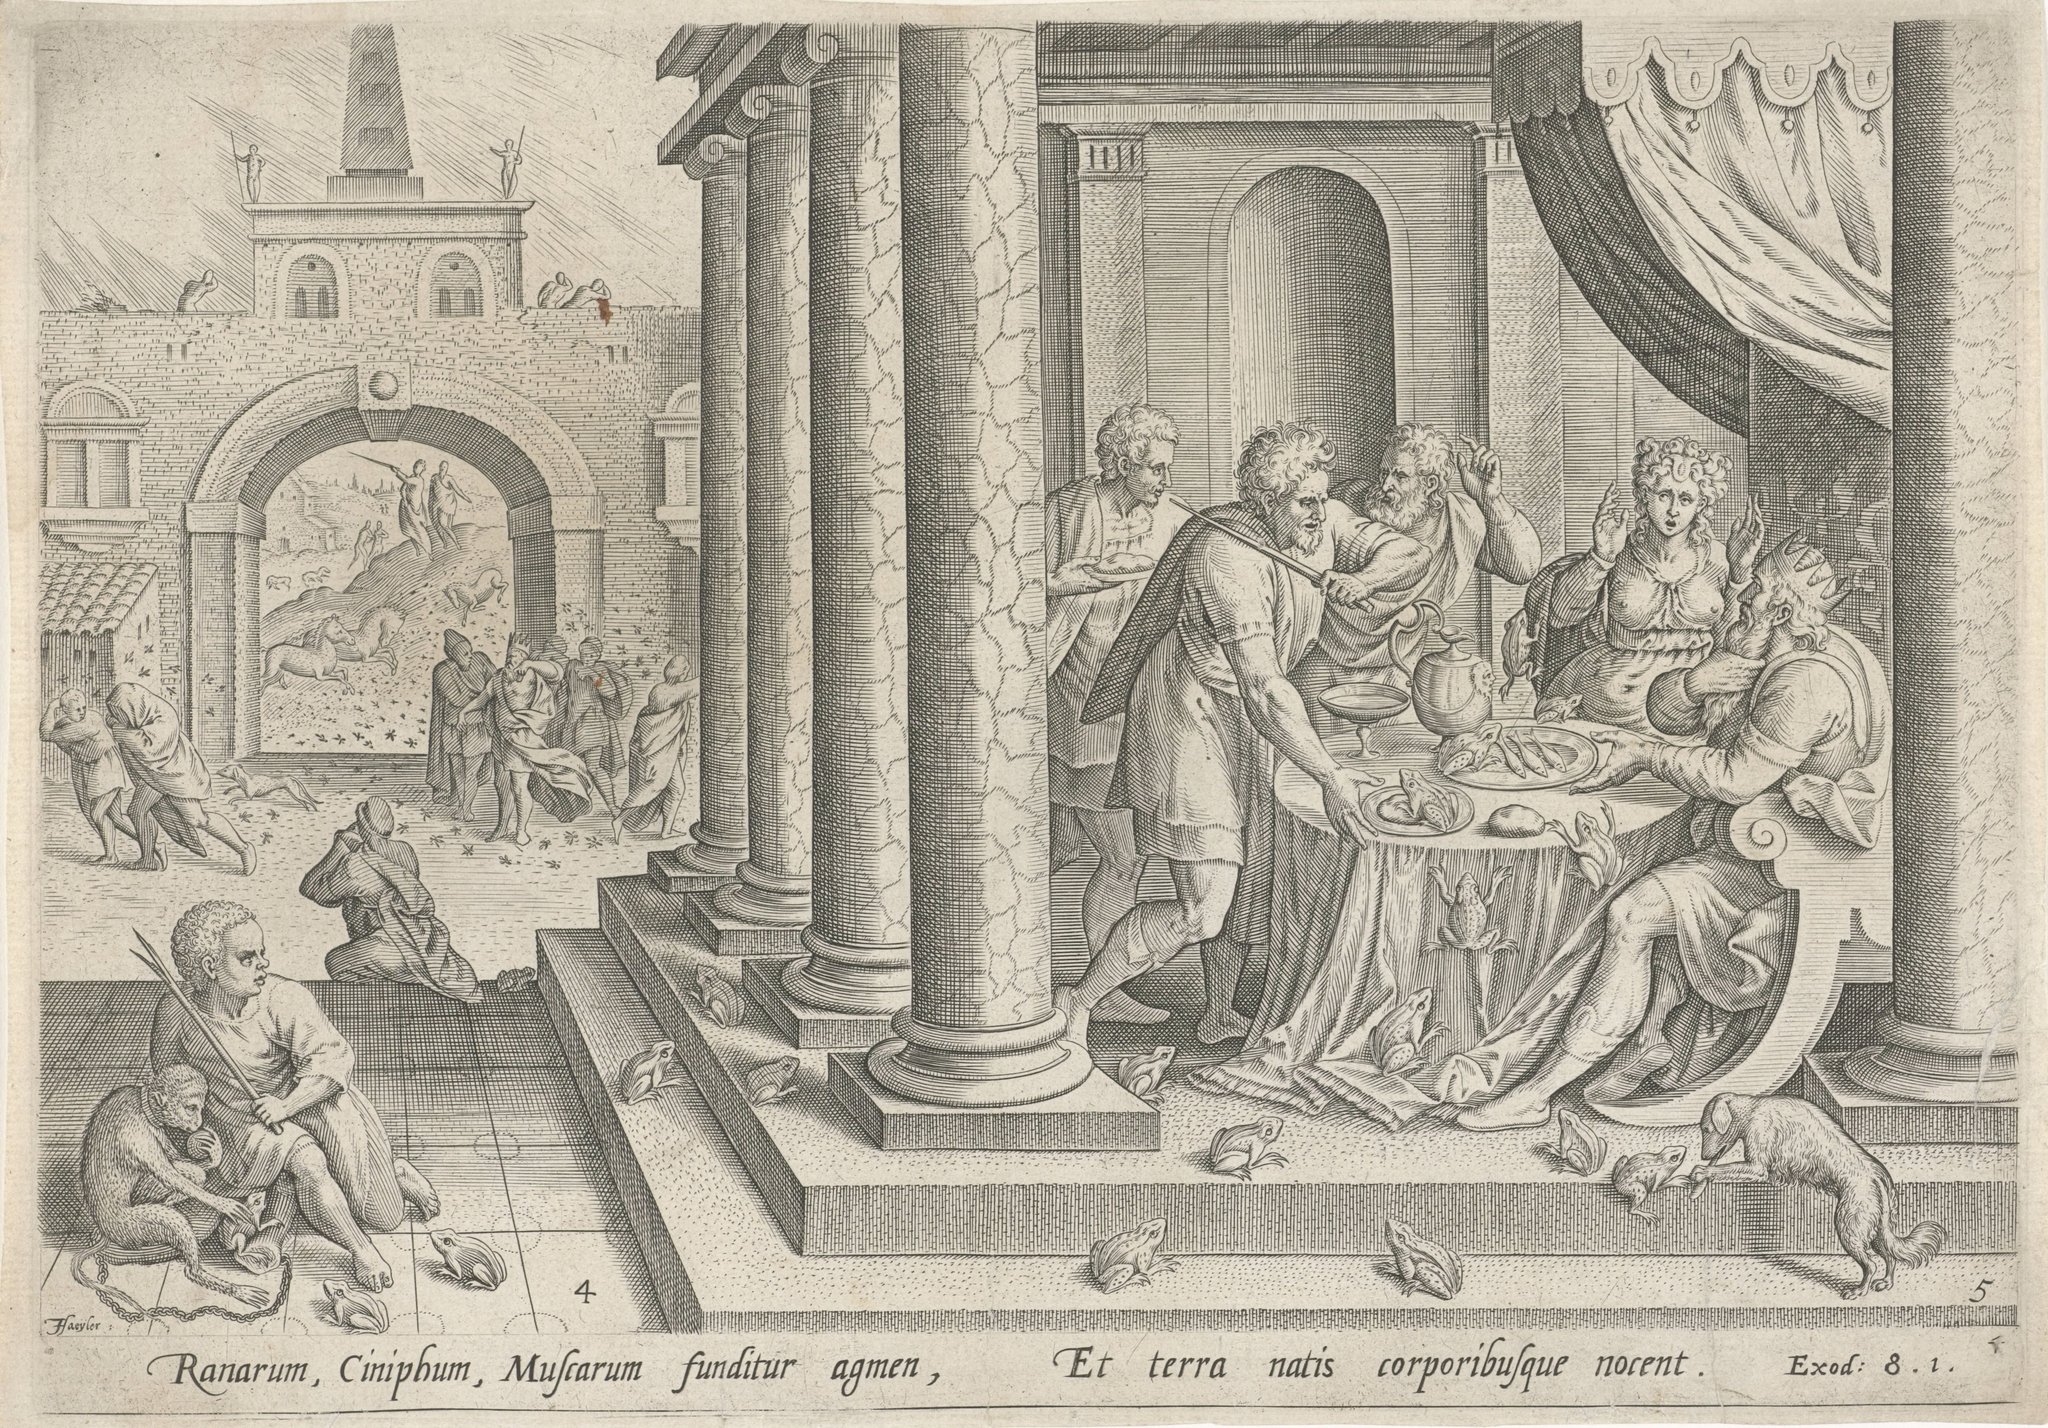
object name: print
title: Plaag van de kikkers en van de muggen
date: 1579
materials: paper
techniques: engraving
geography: antwerp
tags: the plague of frogs: aaron stretches out his hand over the water of egypt; frogs come out and cover the land, the plague of lice: aaron strikes the ground with his rod and the dust turns into lice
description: Op de voorgrond de tweede plaag die God over Egypte liet komen: een kikkerplaag. Een groep mensen aan tafel met rondom hen overal kikkers. Op de achtergrond wordt de farao aangevallen door een groep muggen: de derde plaag van Egypte. Ook op de achtergrond Aäron en Mozes die de plagen oproepen. De prent heeft een Latijns onderschrift.